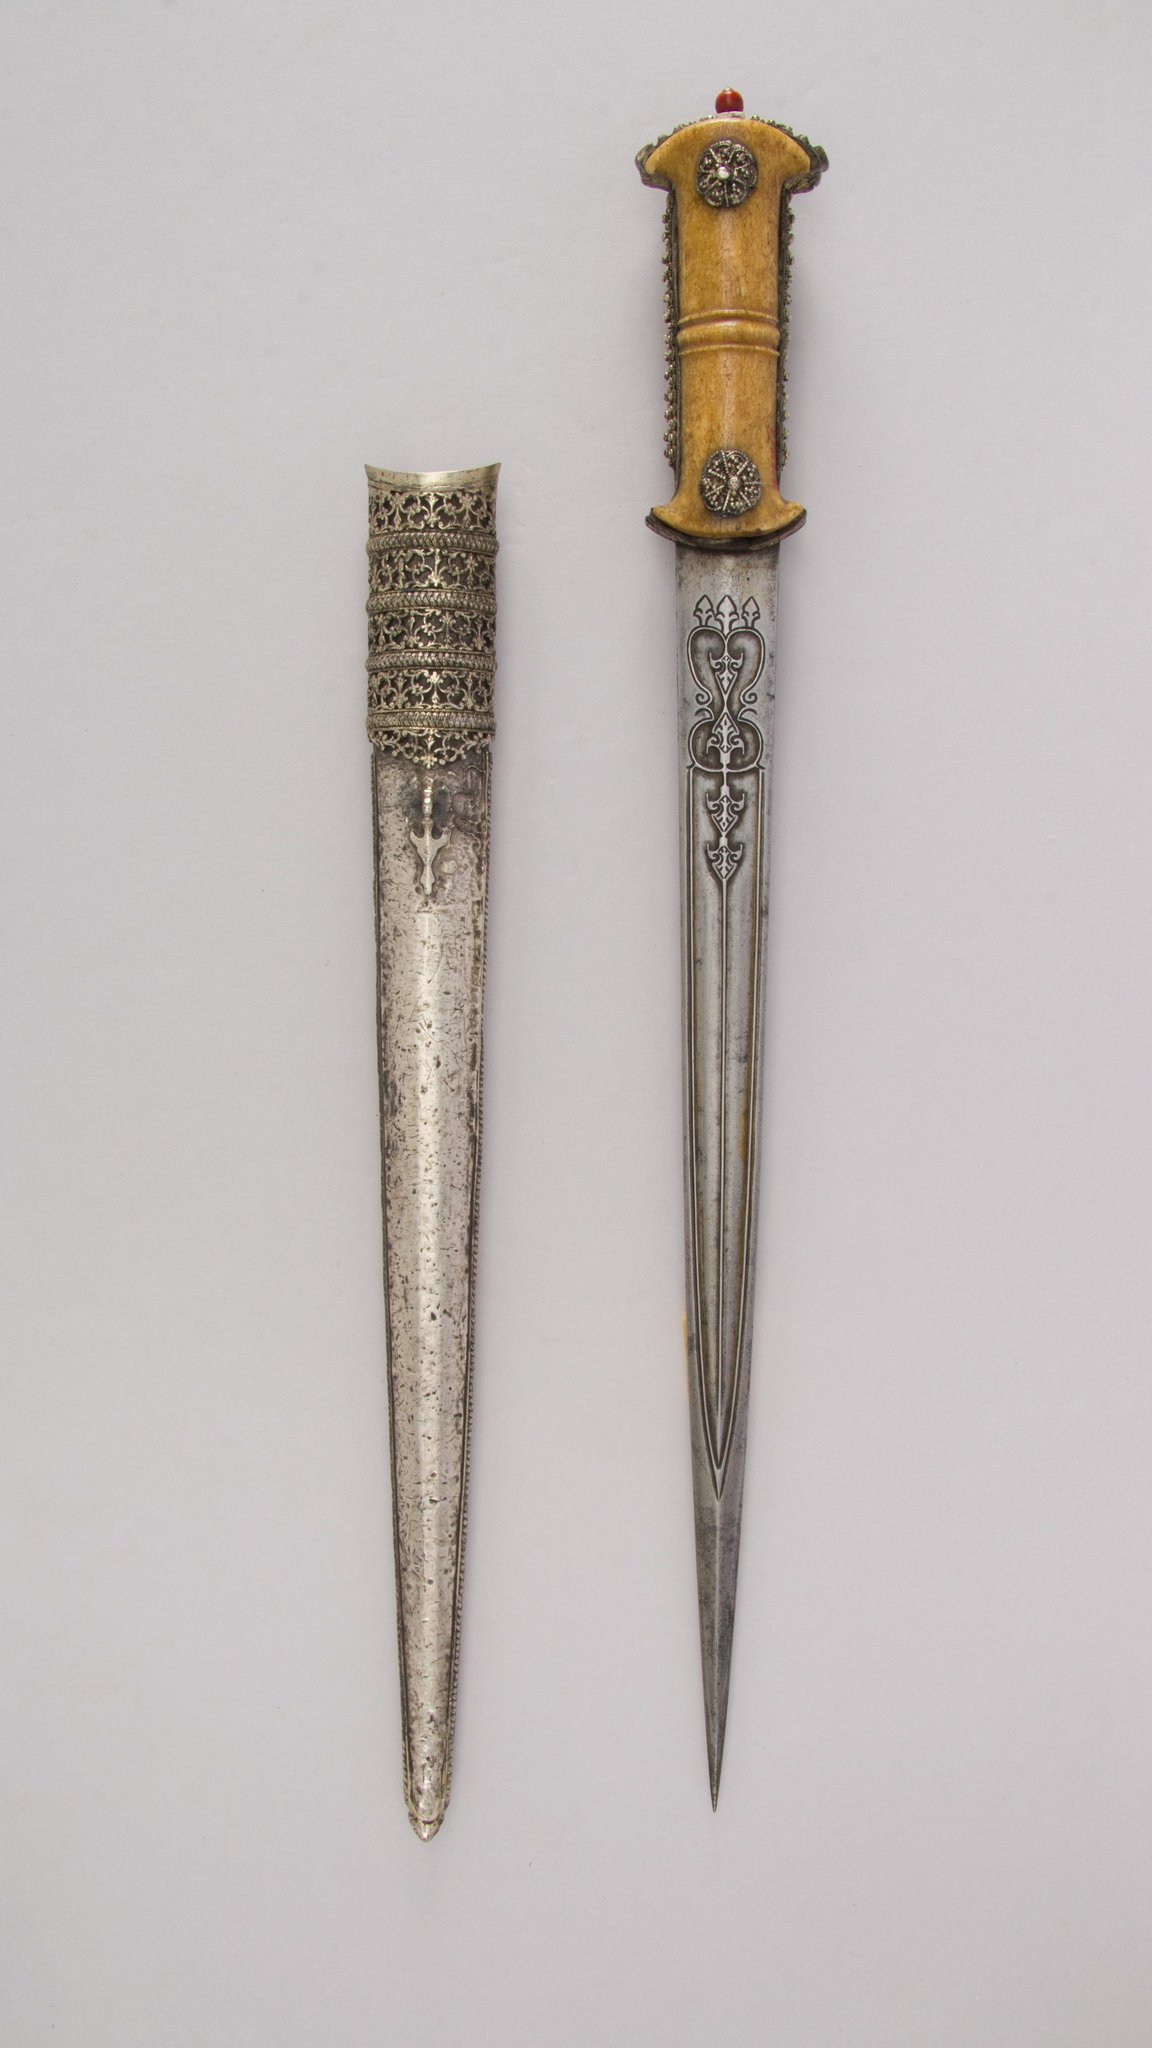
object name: dagger with sheath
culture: ottoman or turkish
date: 1701-1900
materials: coral, ivory, silver, steel, wood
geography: turkey